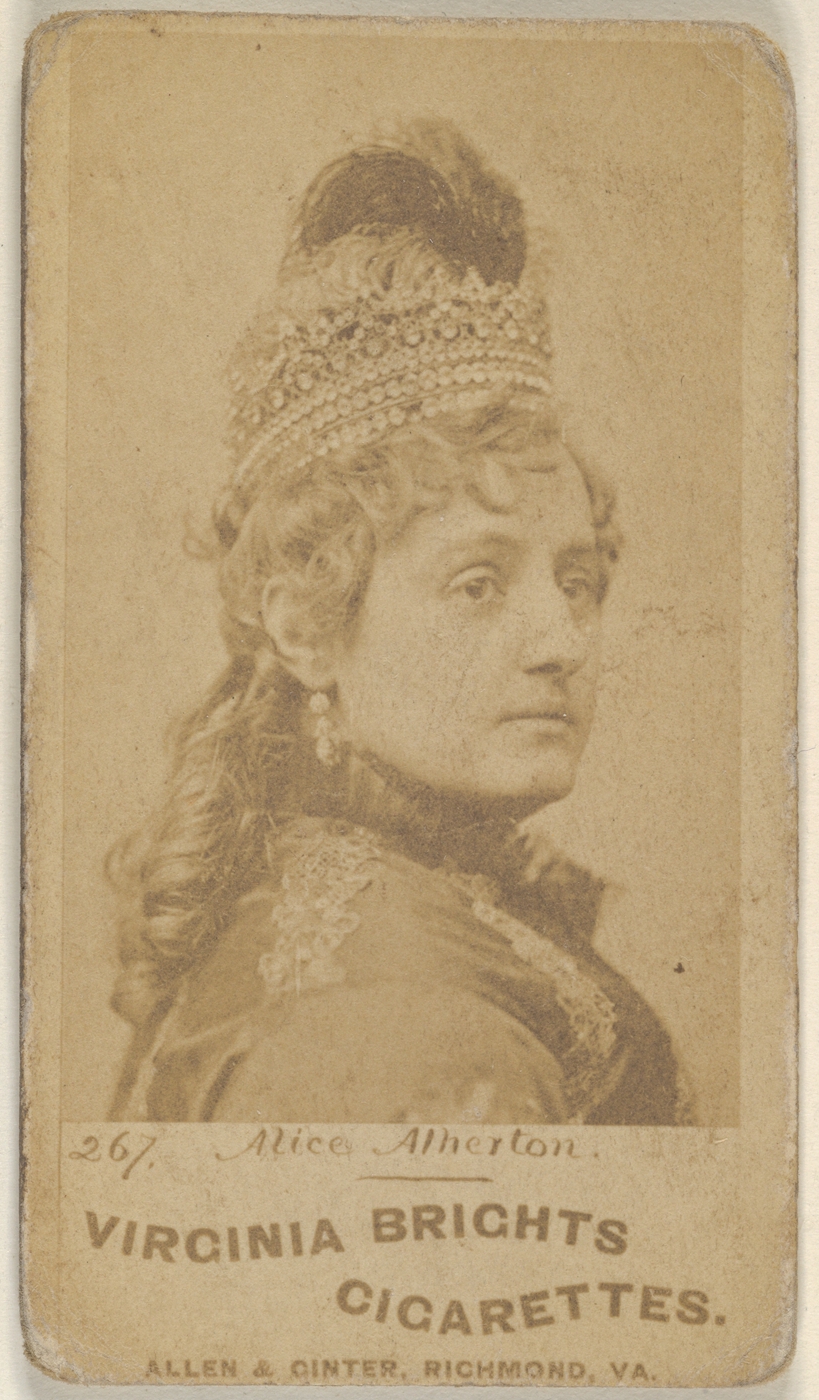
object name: photograph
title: Card 267, Alice Atherton, from the Actors and Actresses series (N45, Type 1) for Virginia Brights Cigarettes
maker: allen & ginter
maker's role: publisher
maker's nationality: american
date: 1888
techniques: albumen silver print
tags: portraits,women,actresses